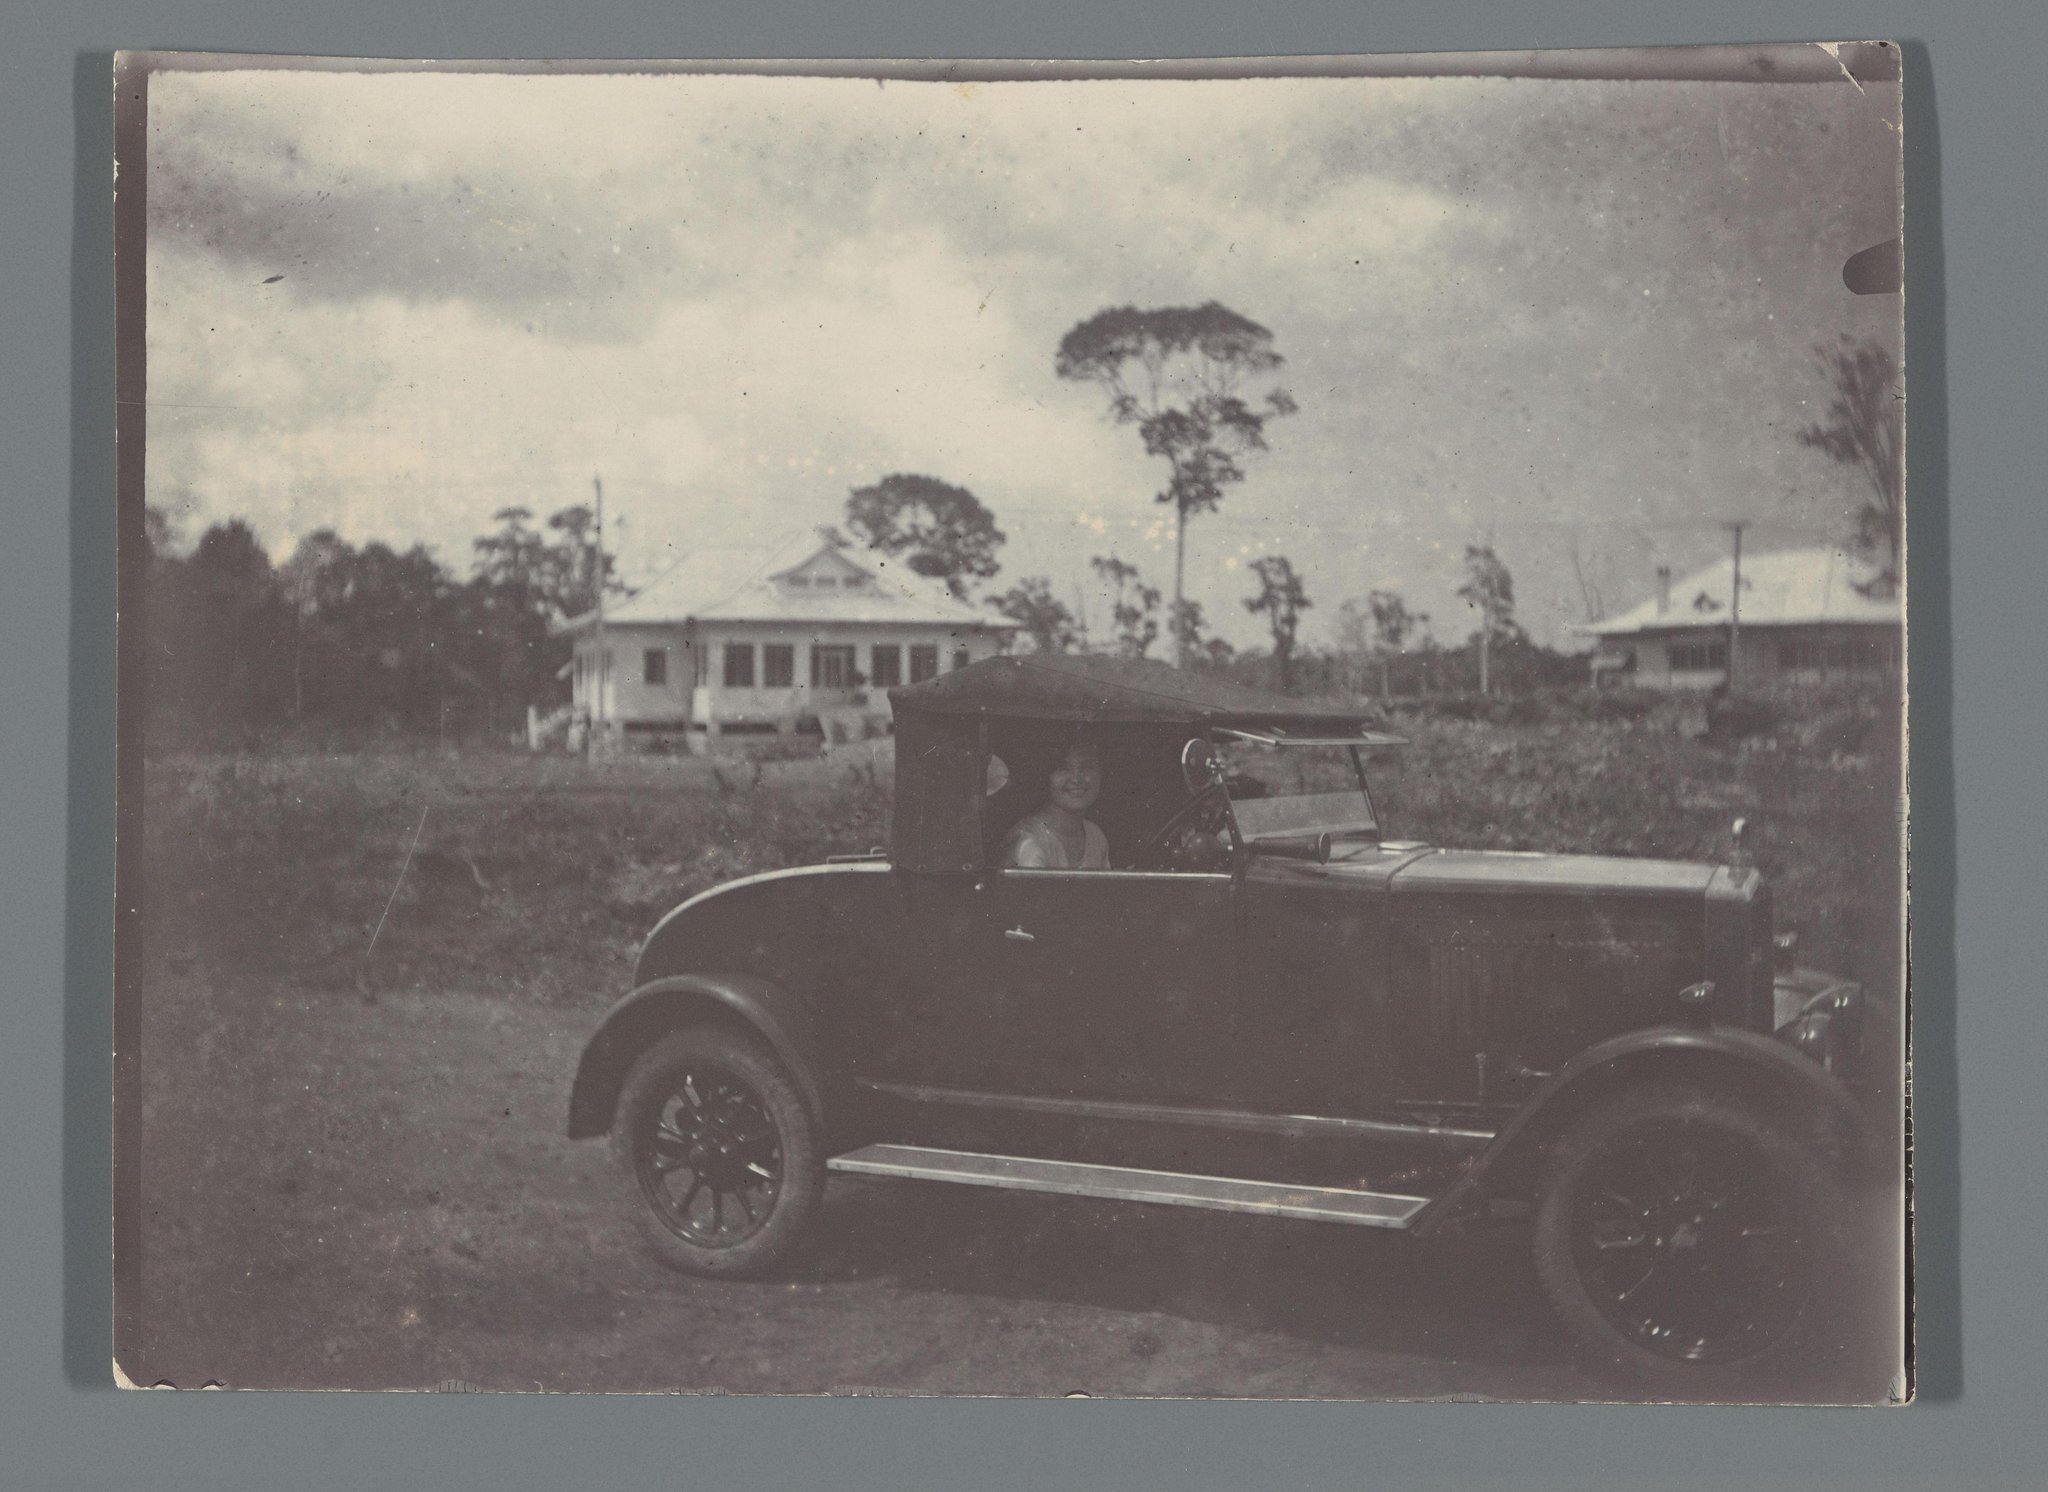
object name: photograph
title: Edith Jetten in een auto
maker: Anonymous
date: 1925-1927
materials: photographic support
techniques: photography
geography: suriname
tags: jetten, familie, moengo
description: Edith Jetten zittend in een auto. Onderdeel van het ensemble met foto's van de familie van ingenieur Jetten in de mijnbouwstad Moengo in Suriname.